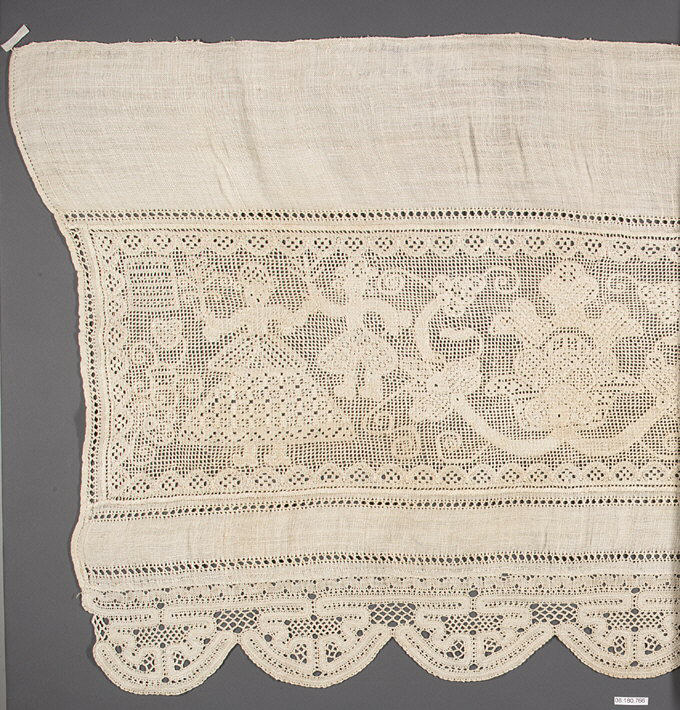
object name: border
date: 1801-1900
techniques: embroidery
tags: human figures